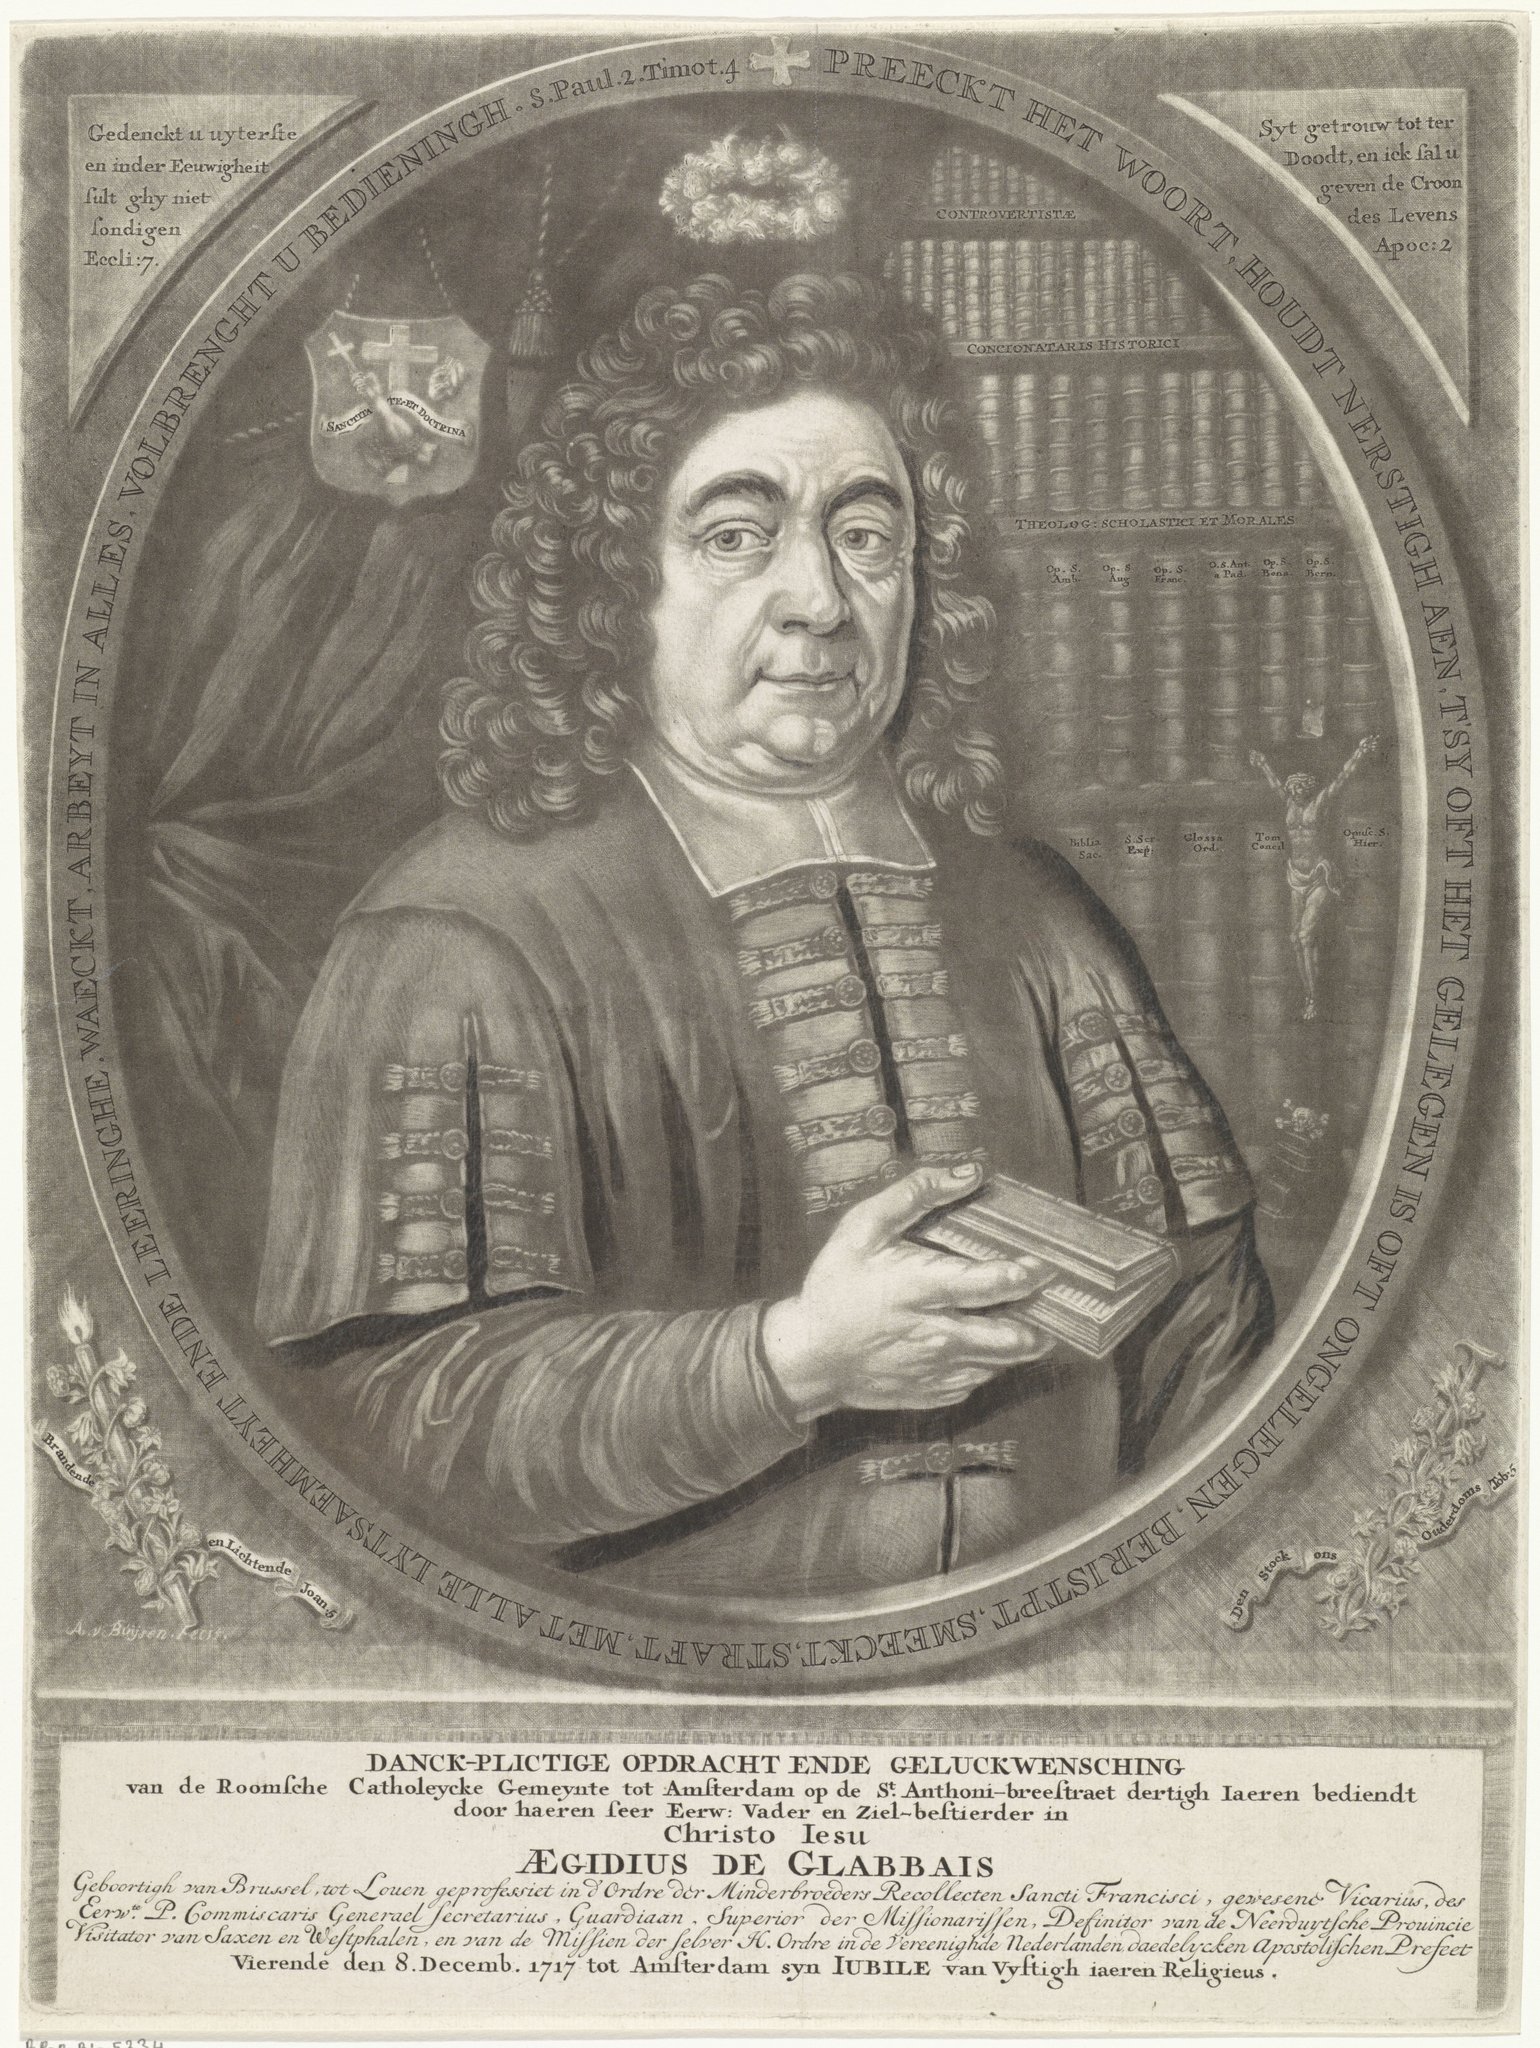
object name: print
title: Portret van Aegidius de Glabbais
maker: andries van buysen (sr.)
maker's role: print maker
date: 1717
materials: paper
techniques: engraving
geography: amsterdam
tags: brussels, priest, historical persons, crucifix ~ personal devotion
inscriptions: collector's mark: Lugt 2228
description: Portret van de geestelijke Aegidius de Glabbais. Hij staat voor een boekenkast waarvoor een crucifix. De prent is uitgegeven ter ere van het 50-jarig priesterschap van De Glabbais en om te herdenken dat hij de Moses en Aaronparochie 30 jaar had gediend.